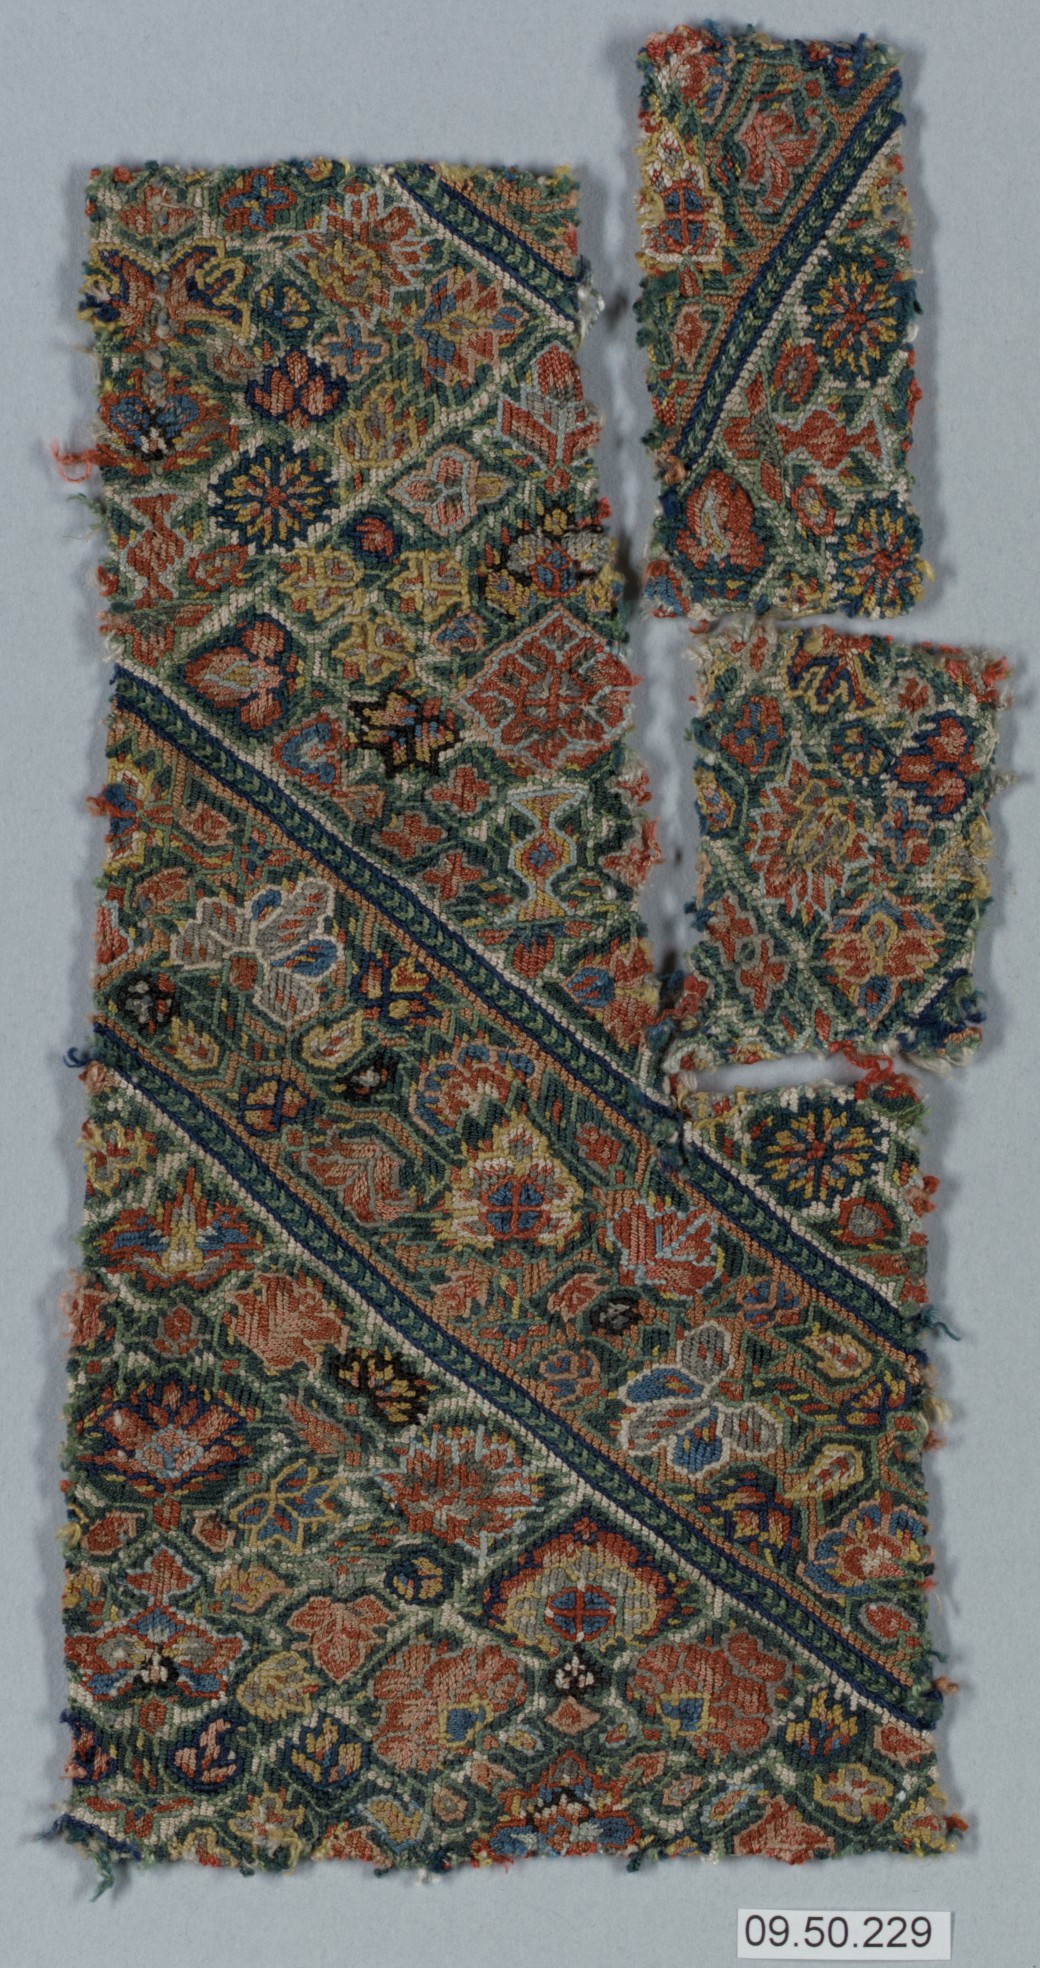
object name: textile fragment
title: Fragment from Women's Trousers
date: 1701-1800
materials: cotton, silk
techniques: embroidery, weave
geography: iran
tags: flowers